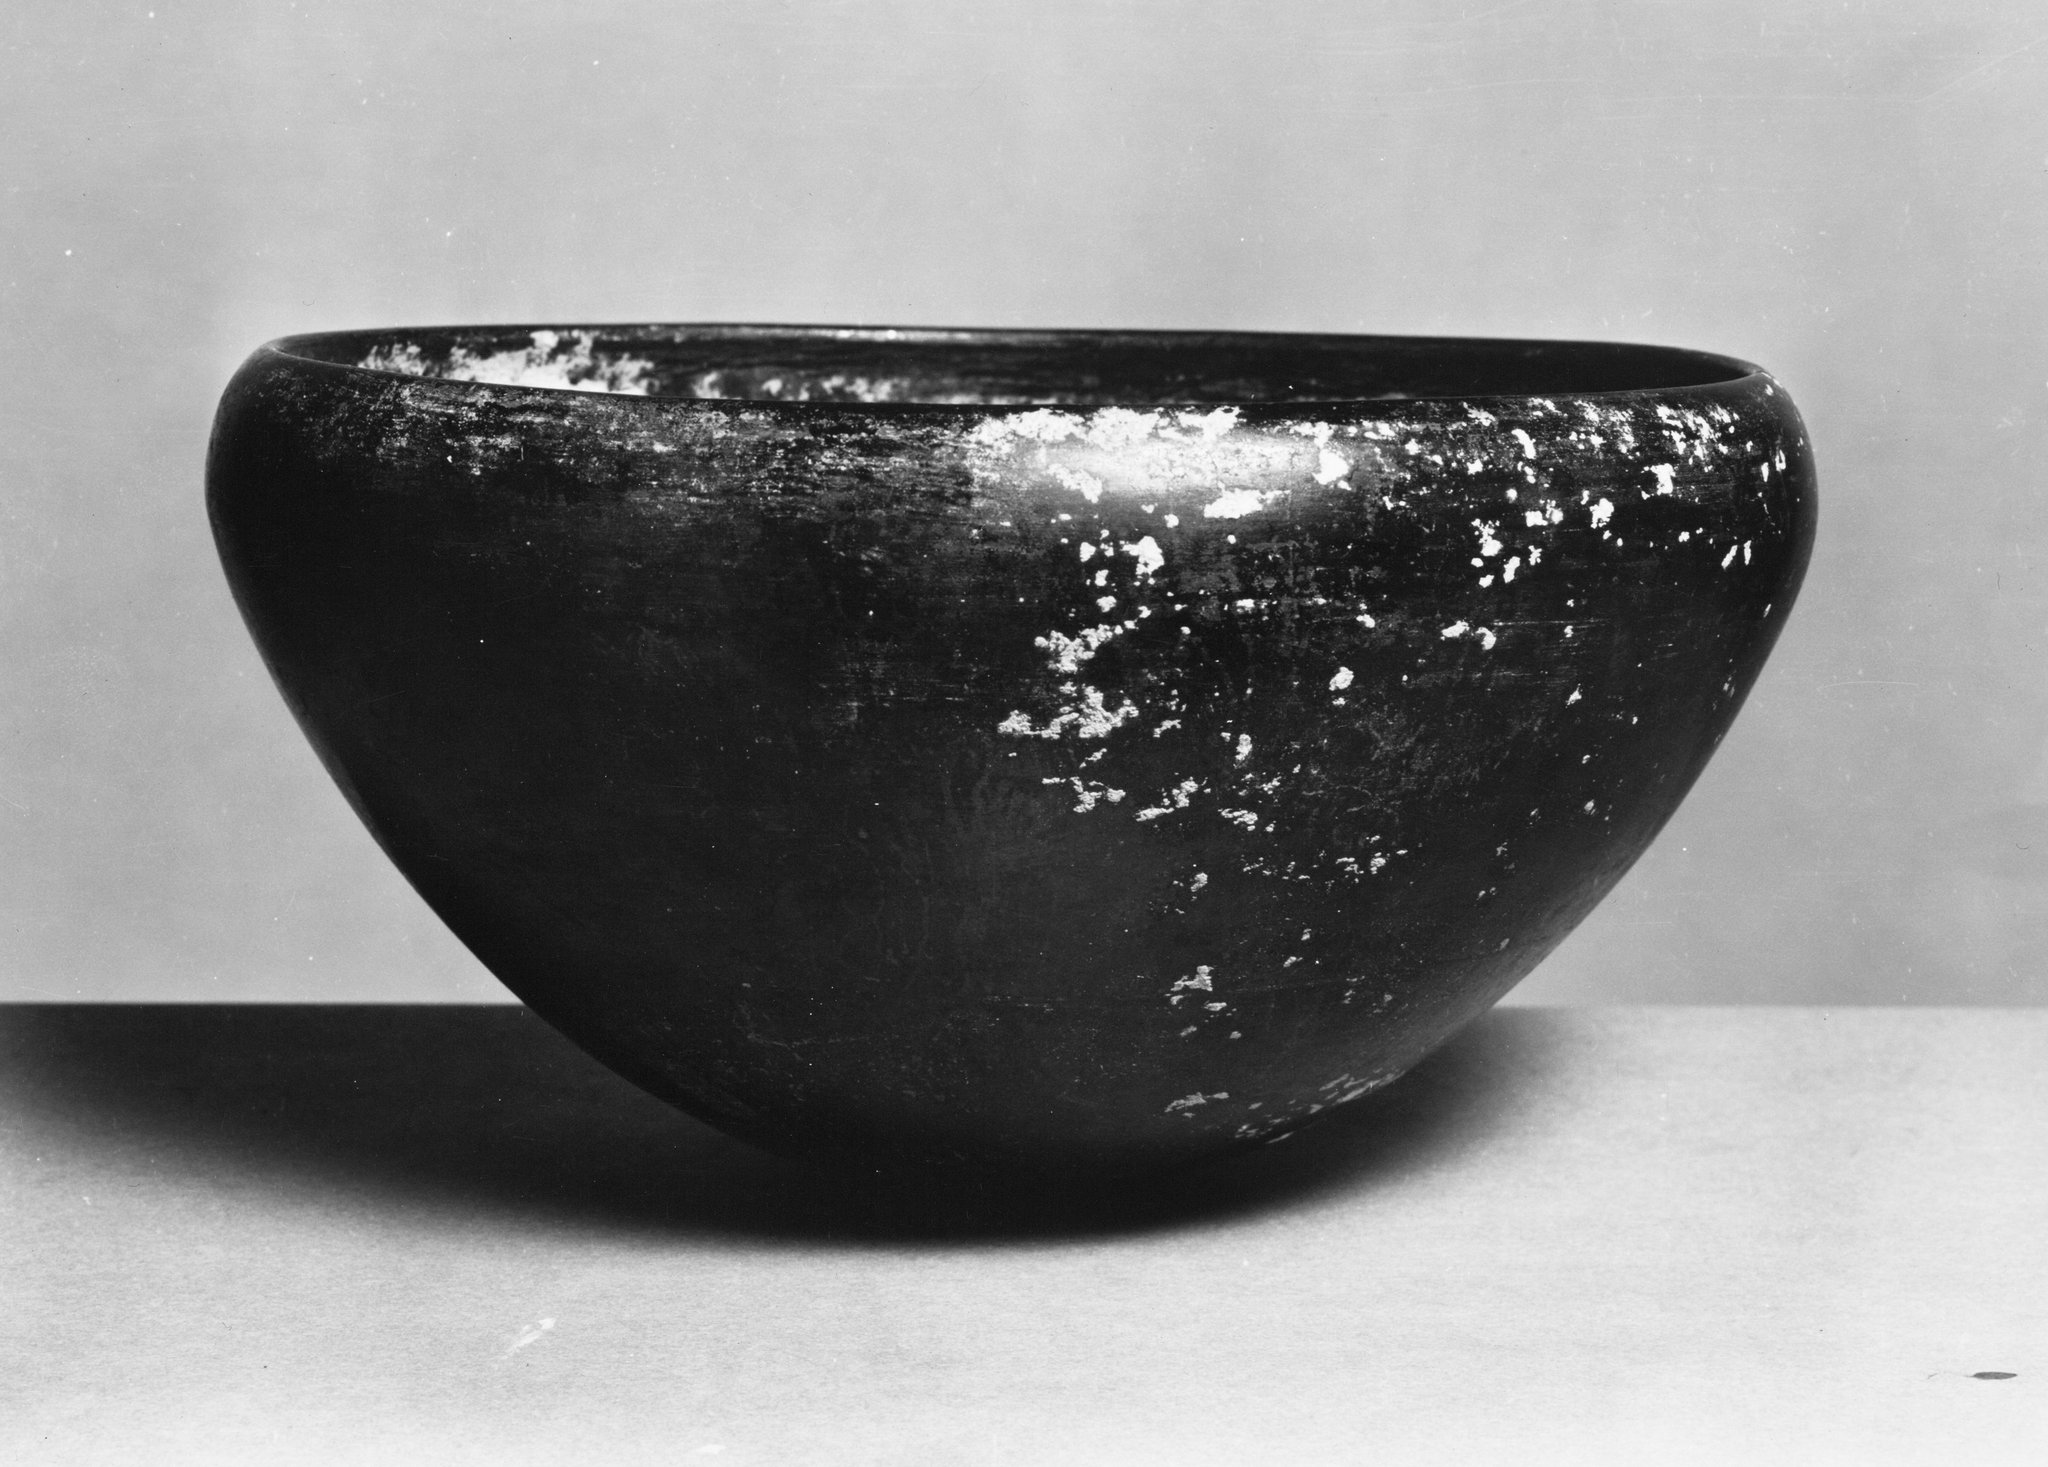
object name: bowl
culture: chinese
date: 3000-2001 BCE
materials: pottery